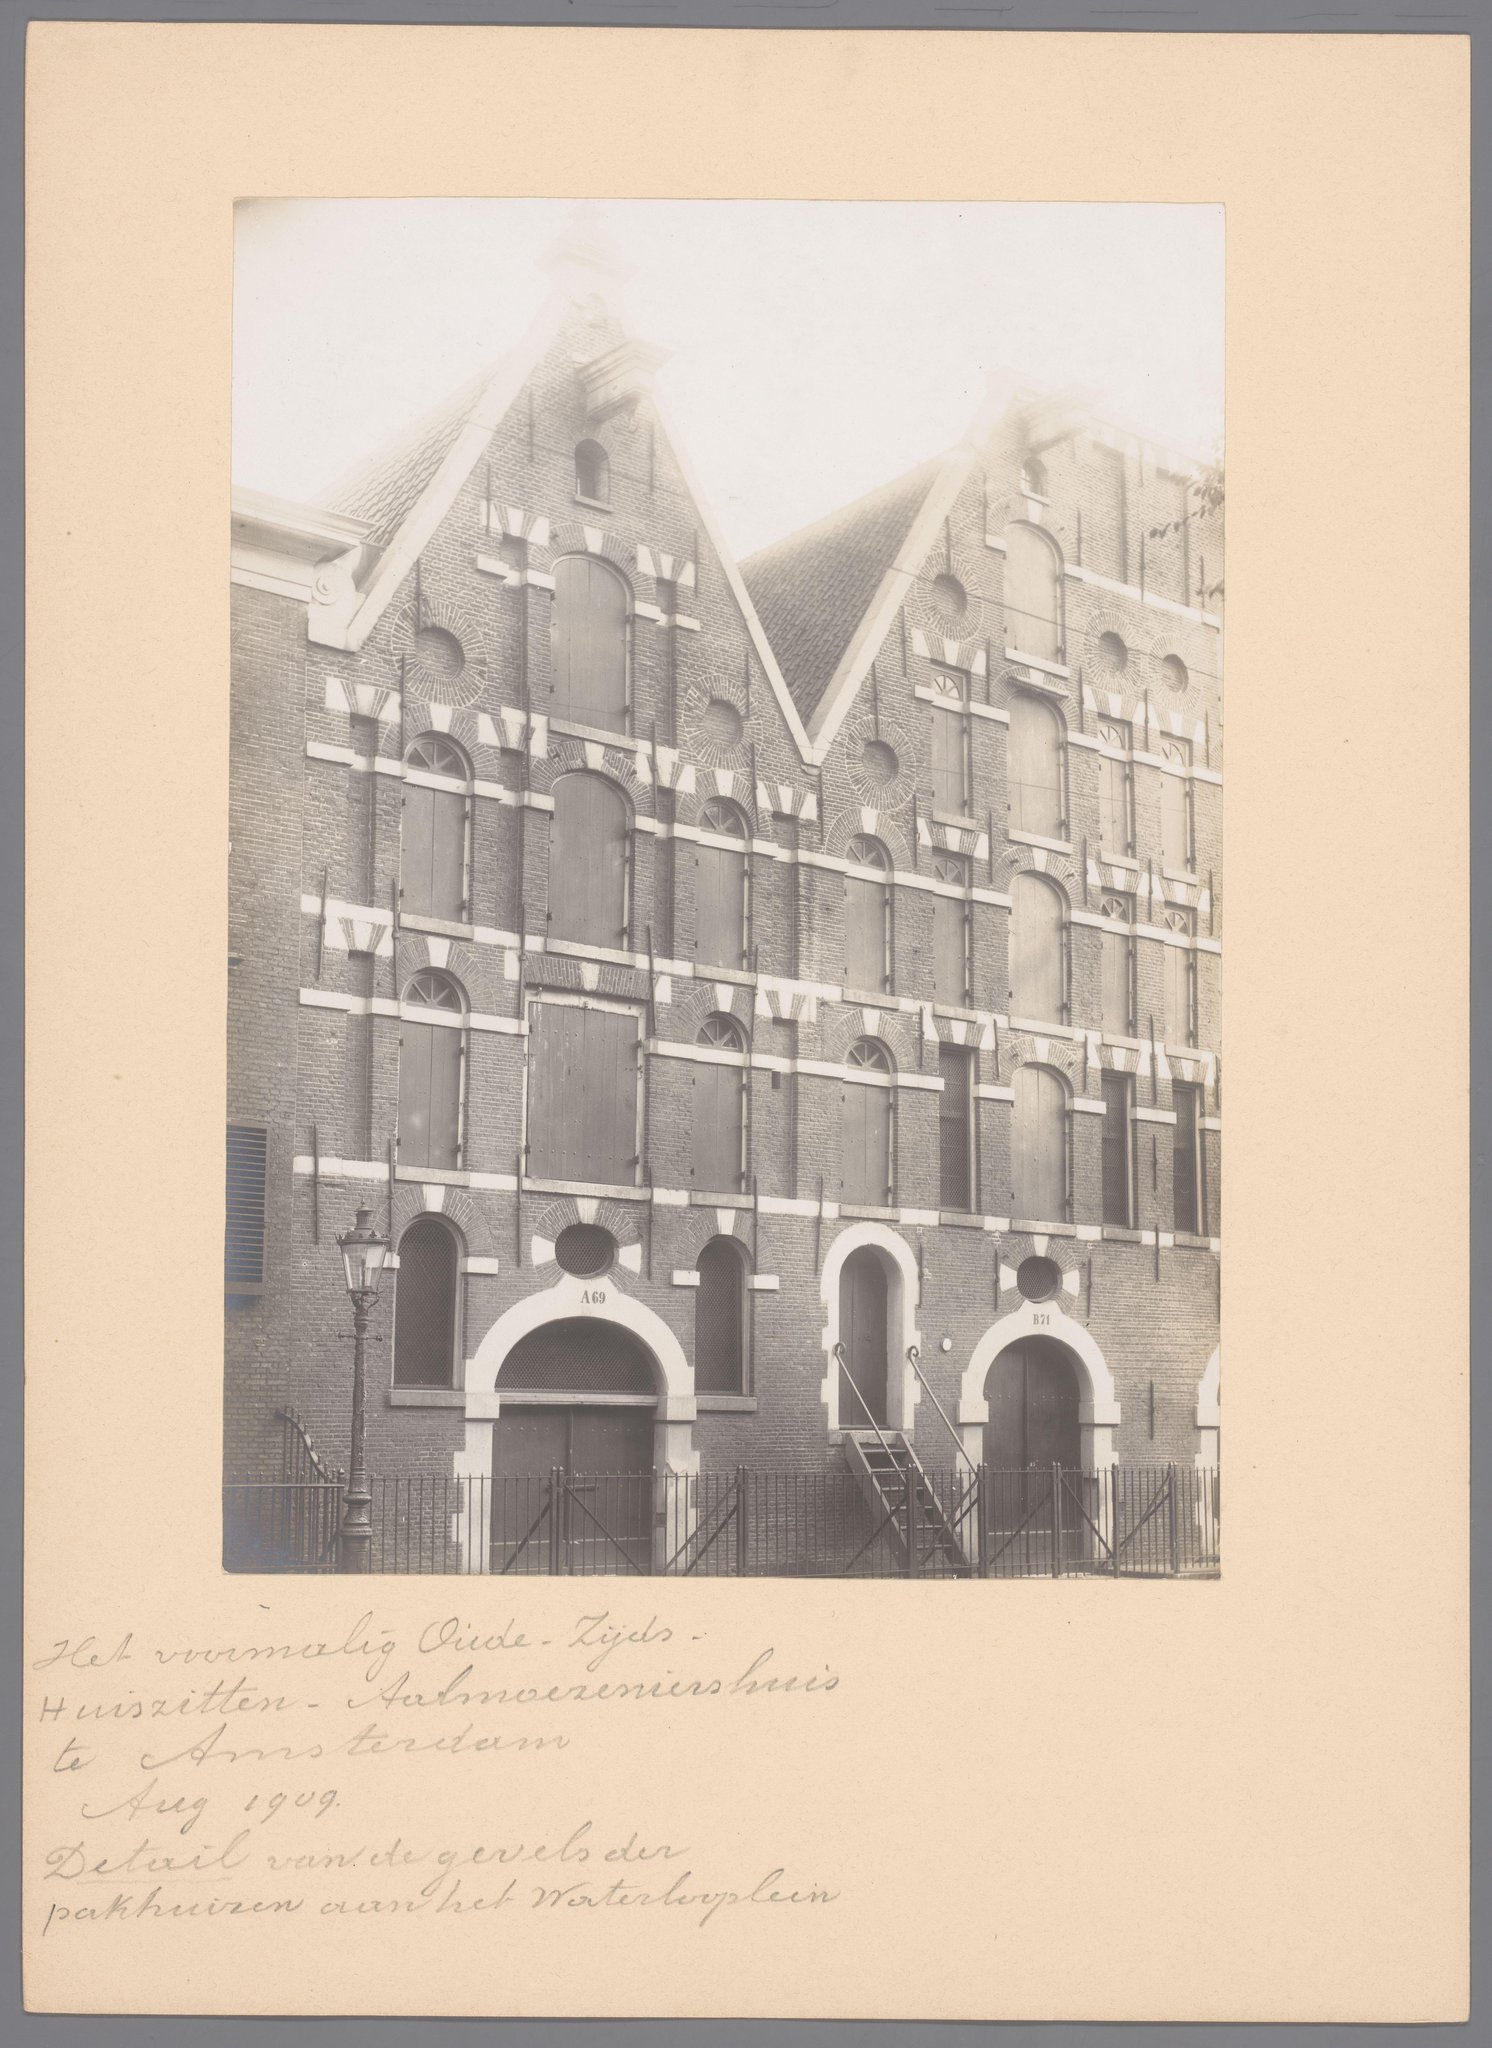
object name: photograph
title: Gevel van het Arsenaal of de stadsturfpakhuizen te Amsterdam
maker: anoniem (monumentenzorg)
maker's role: fotograaf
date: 1909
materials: cardboard, photographic support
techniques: gelatin silver print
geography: waterlooplein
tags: large-scale structure for storage, e.g.: warehouse, depot, silo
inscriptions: annotation: ‘Het voormalig Oude-Zijds-Huiszitten-Aalmoezeniershuis te Amsterdam/ Aug 1909/ Detail van de gevels der pakhuizen aan het Waterlooplein’